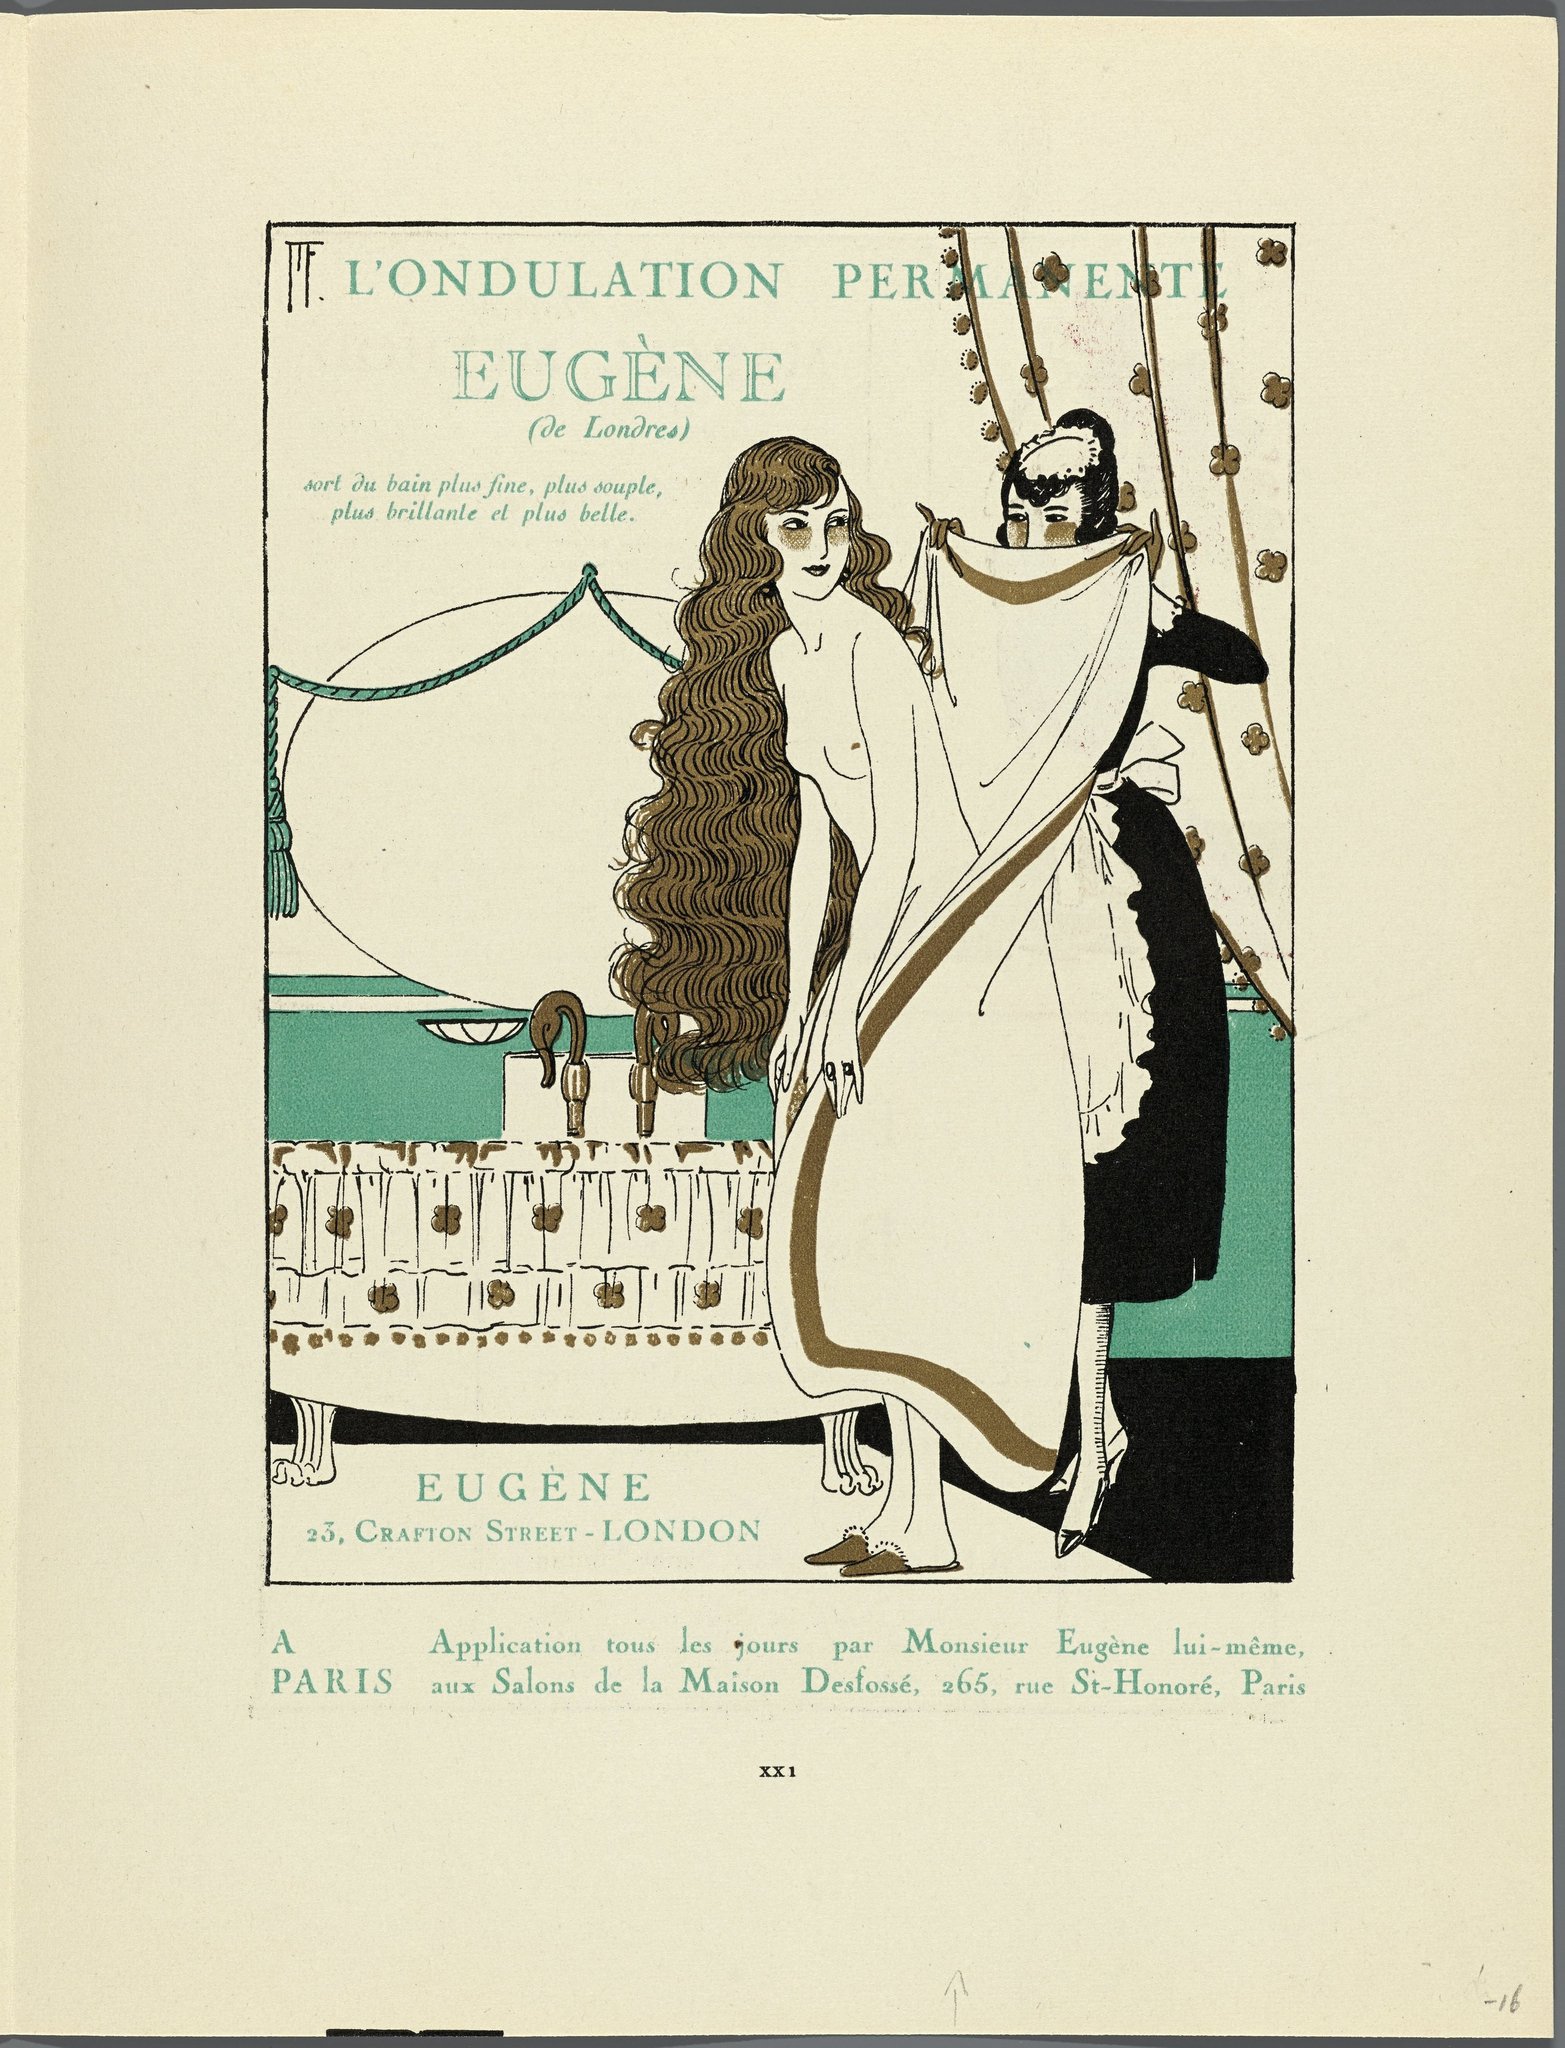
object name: fashion print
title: Gazette du Bon Ton, 1920 - No. 3, p. XXI: L'Ondulation permanente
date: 1920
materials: paper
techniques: lithograph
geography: london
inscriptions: date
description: Advertentie voor permanent. "L'Ondulation permanente Eugène (de Londres)" Een naakte jonge vrouw met zeer lang krullend haar krijgt een badlaken omgeslagen door een bediende . Achter haar een bad op pootjes.